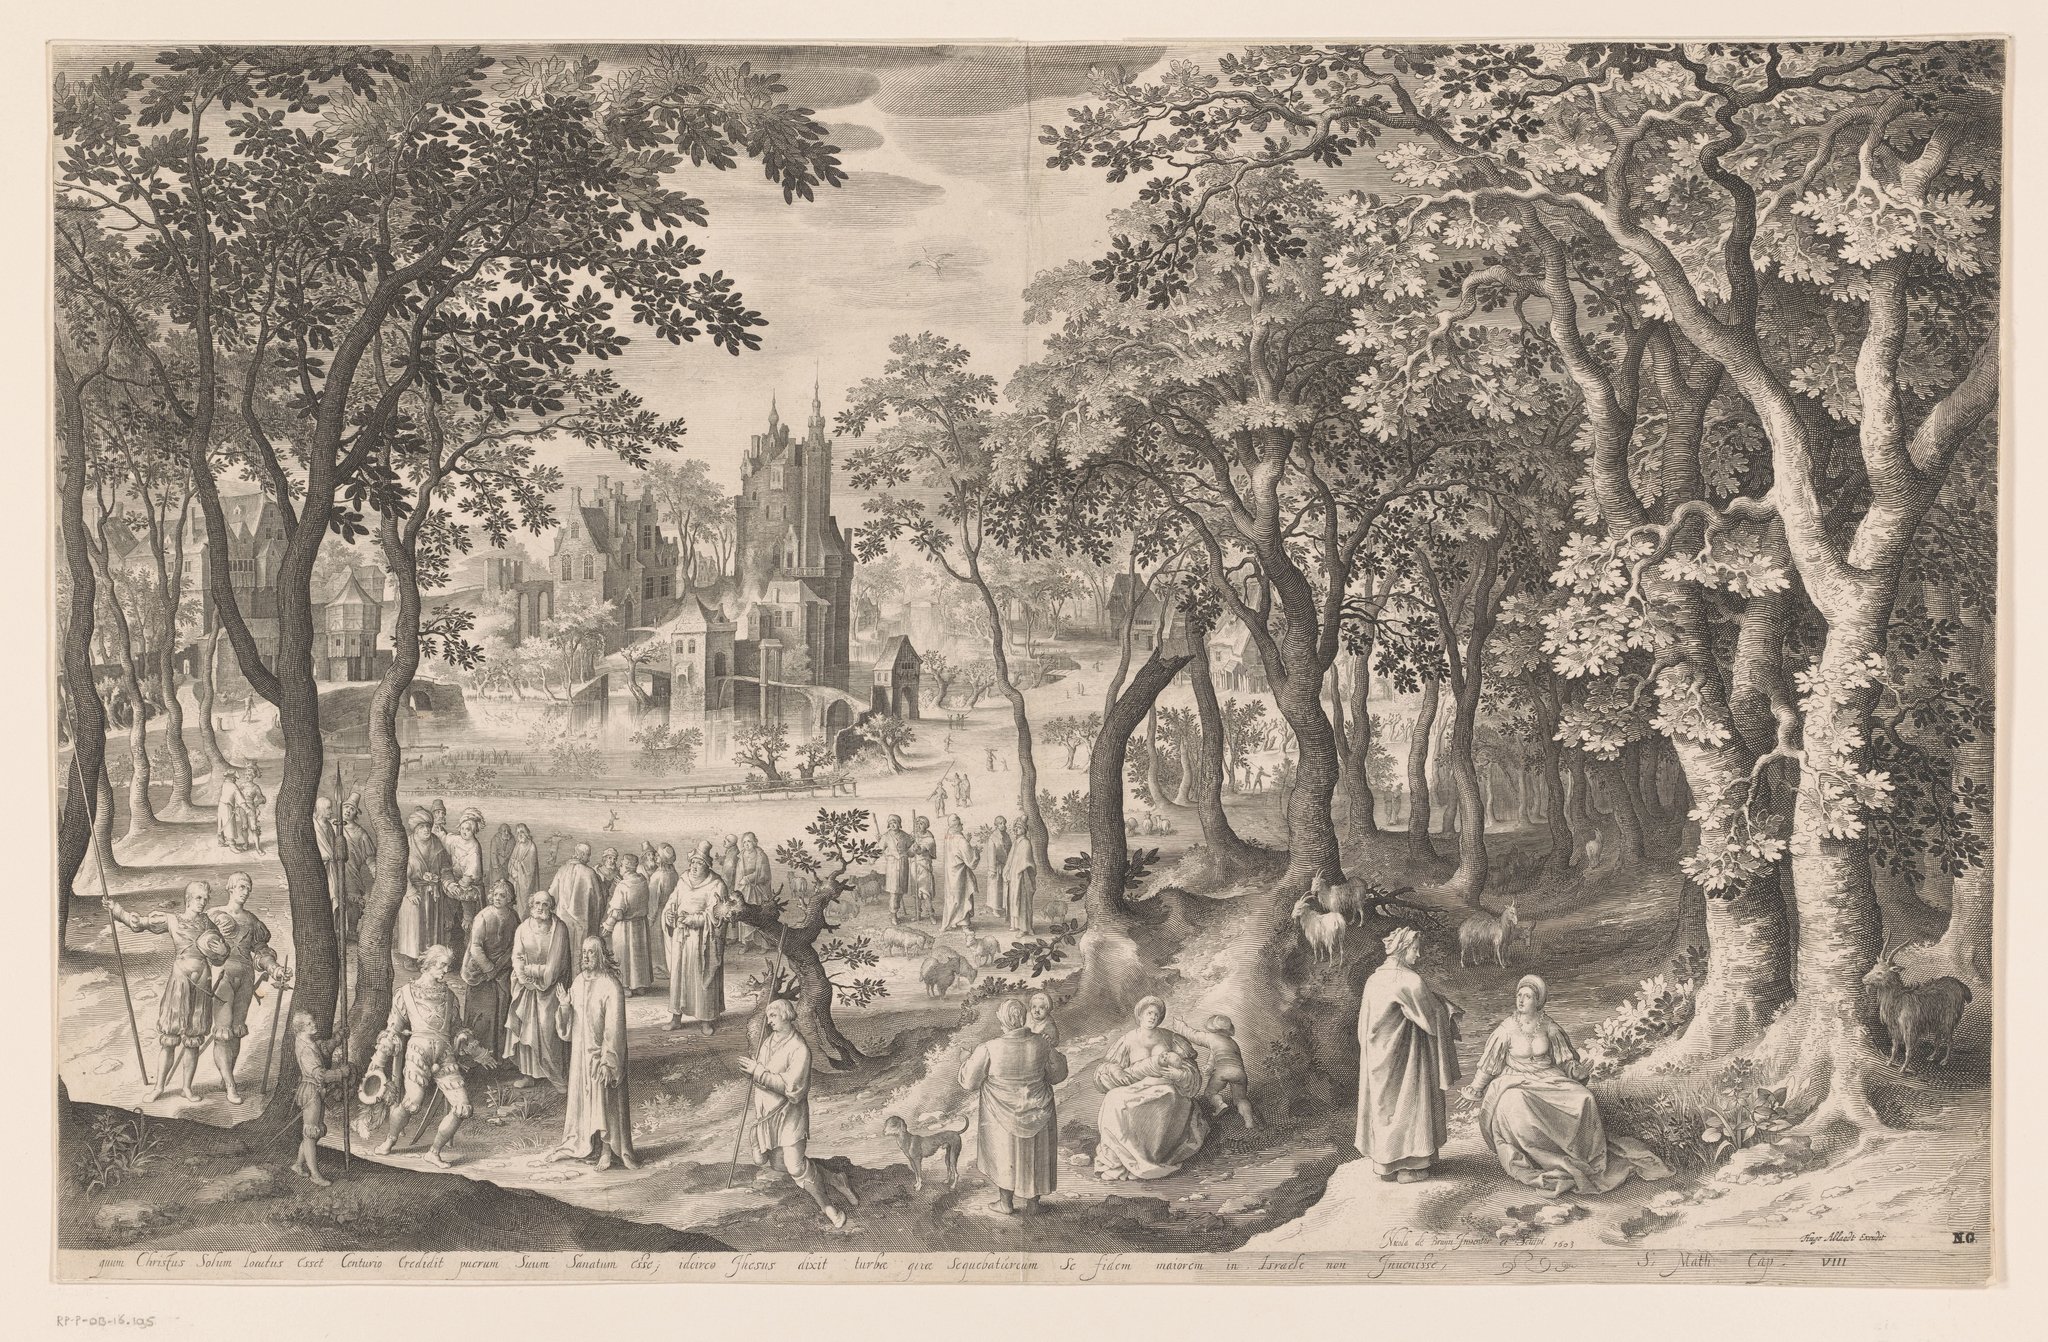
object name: print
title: Genezing van de knecht van de Hoofdman van Kafarnaüm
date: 1603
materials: paper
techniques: engraving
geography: amsterdam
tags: the centurion of capernaum, kneeling before christ, begs him to heal his paralytic servant (or son) (matthew 8:5-13; luke 7:1-10; john 4:46-54), landscape with tower or castle (+ city(-scape) with figures, staffage)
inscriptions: collector's mark: Lugt 1967, collector's mark: Lugt 2228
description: Links knielt de hoofdman van Kafarnaüm voor Christus. Hij smeekt om de genezing van zijn knecht. Rondom Christus zijn leerlingen. Op de achtergrond een kasteel. De prent heeft een Latijns onderschrift.